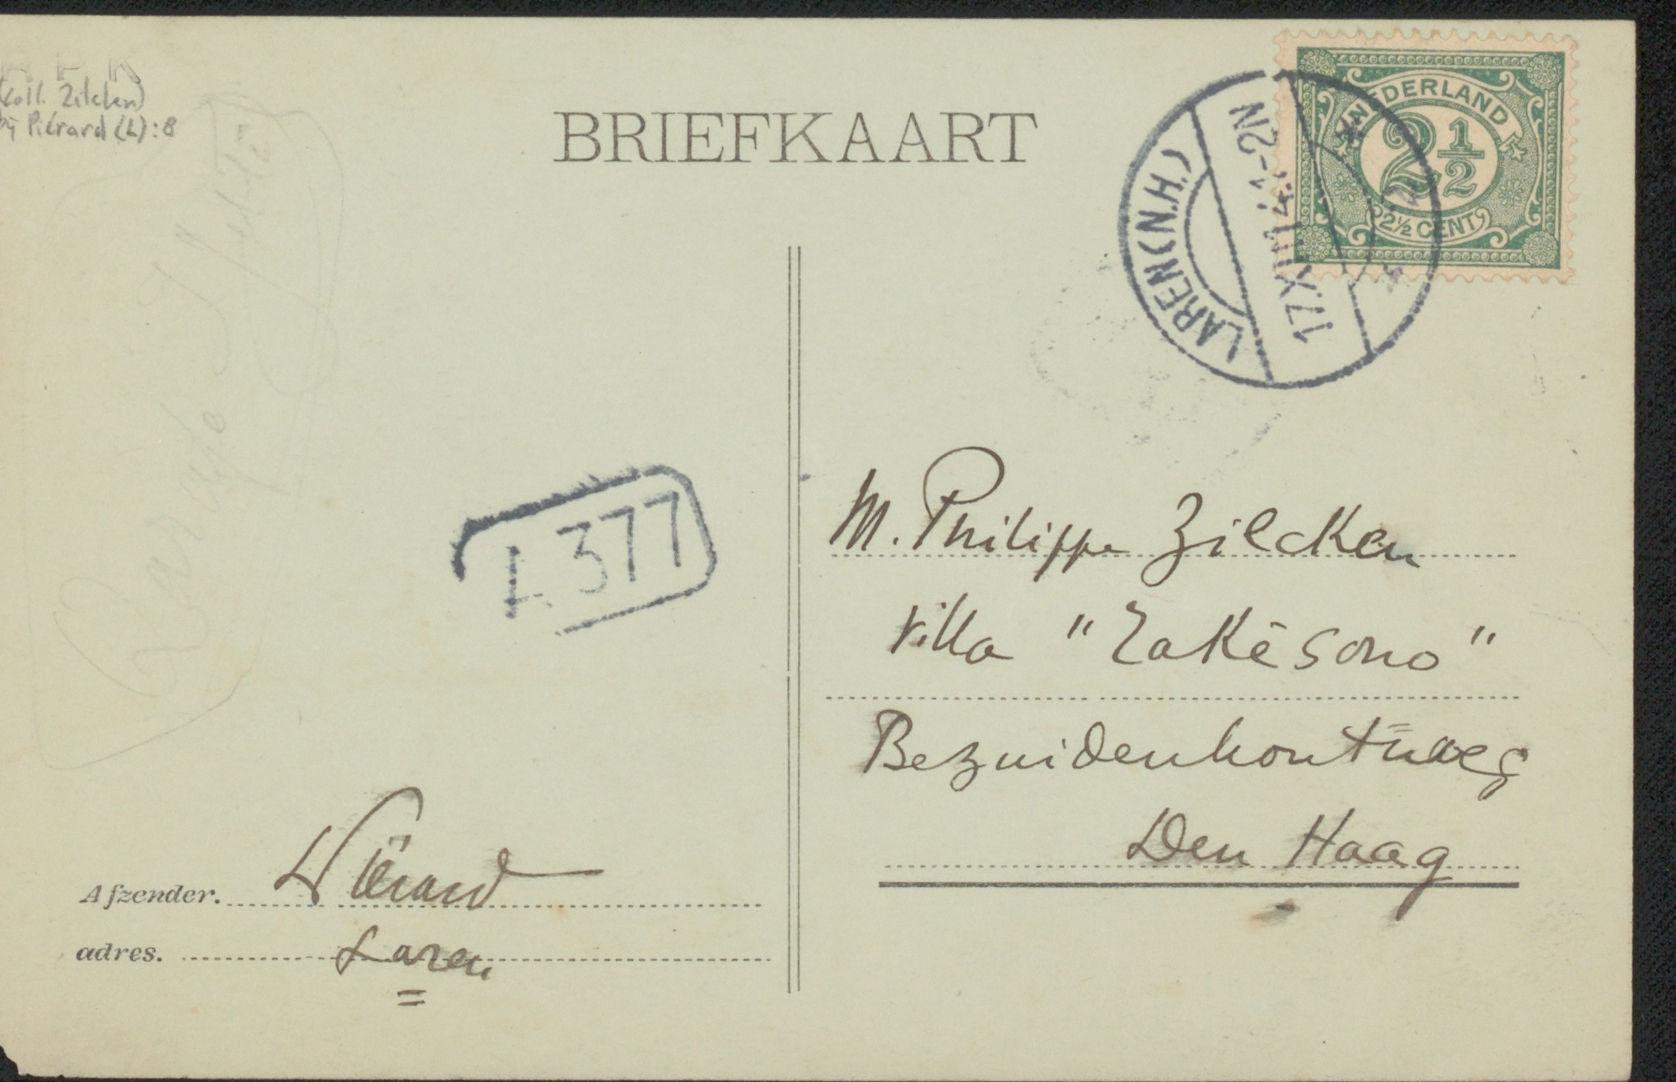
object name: postcard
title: Briefkaart aan Philip Zilcken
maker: louis piérard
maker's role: letterkundige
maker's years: 1886-1951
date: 1914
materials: cardboard, pencil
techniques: pen, writing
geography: laren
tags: print maker, draughtsman, isaac israels, léon paschal, philip zilcken, the hague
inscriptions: collector's mark: ‘RPK’